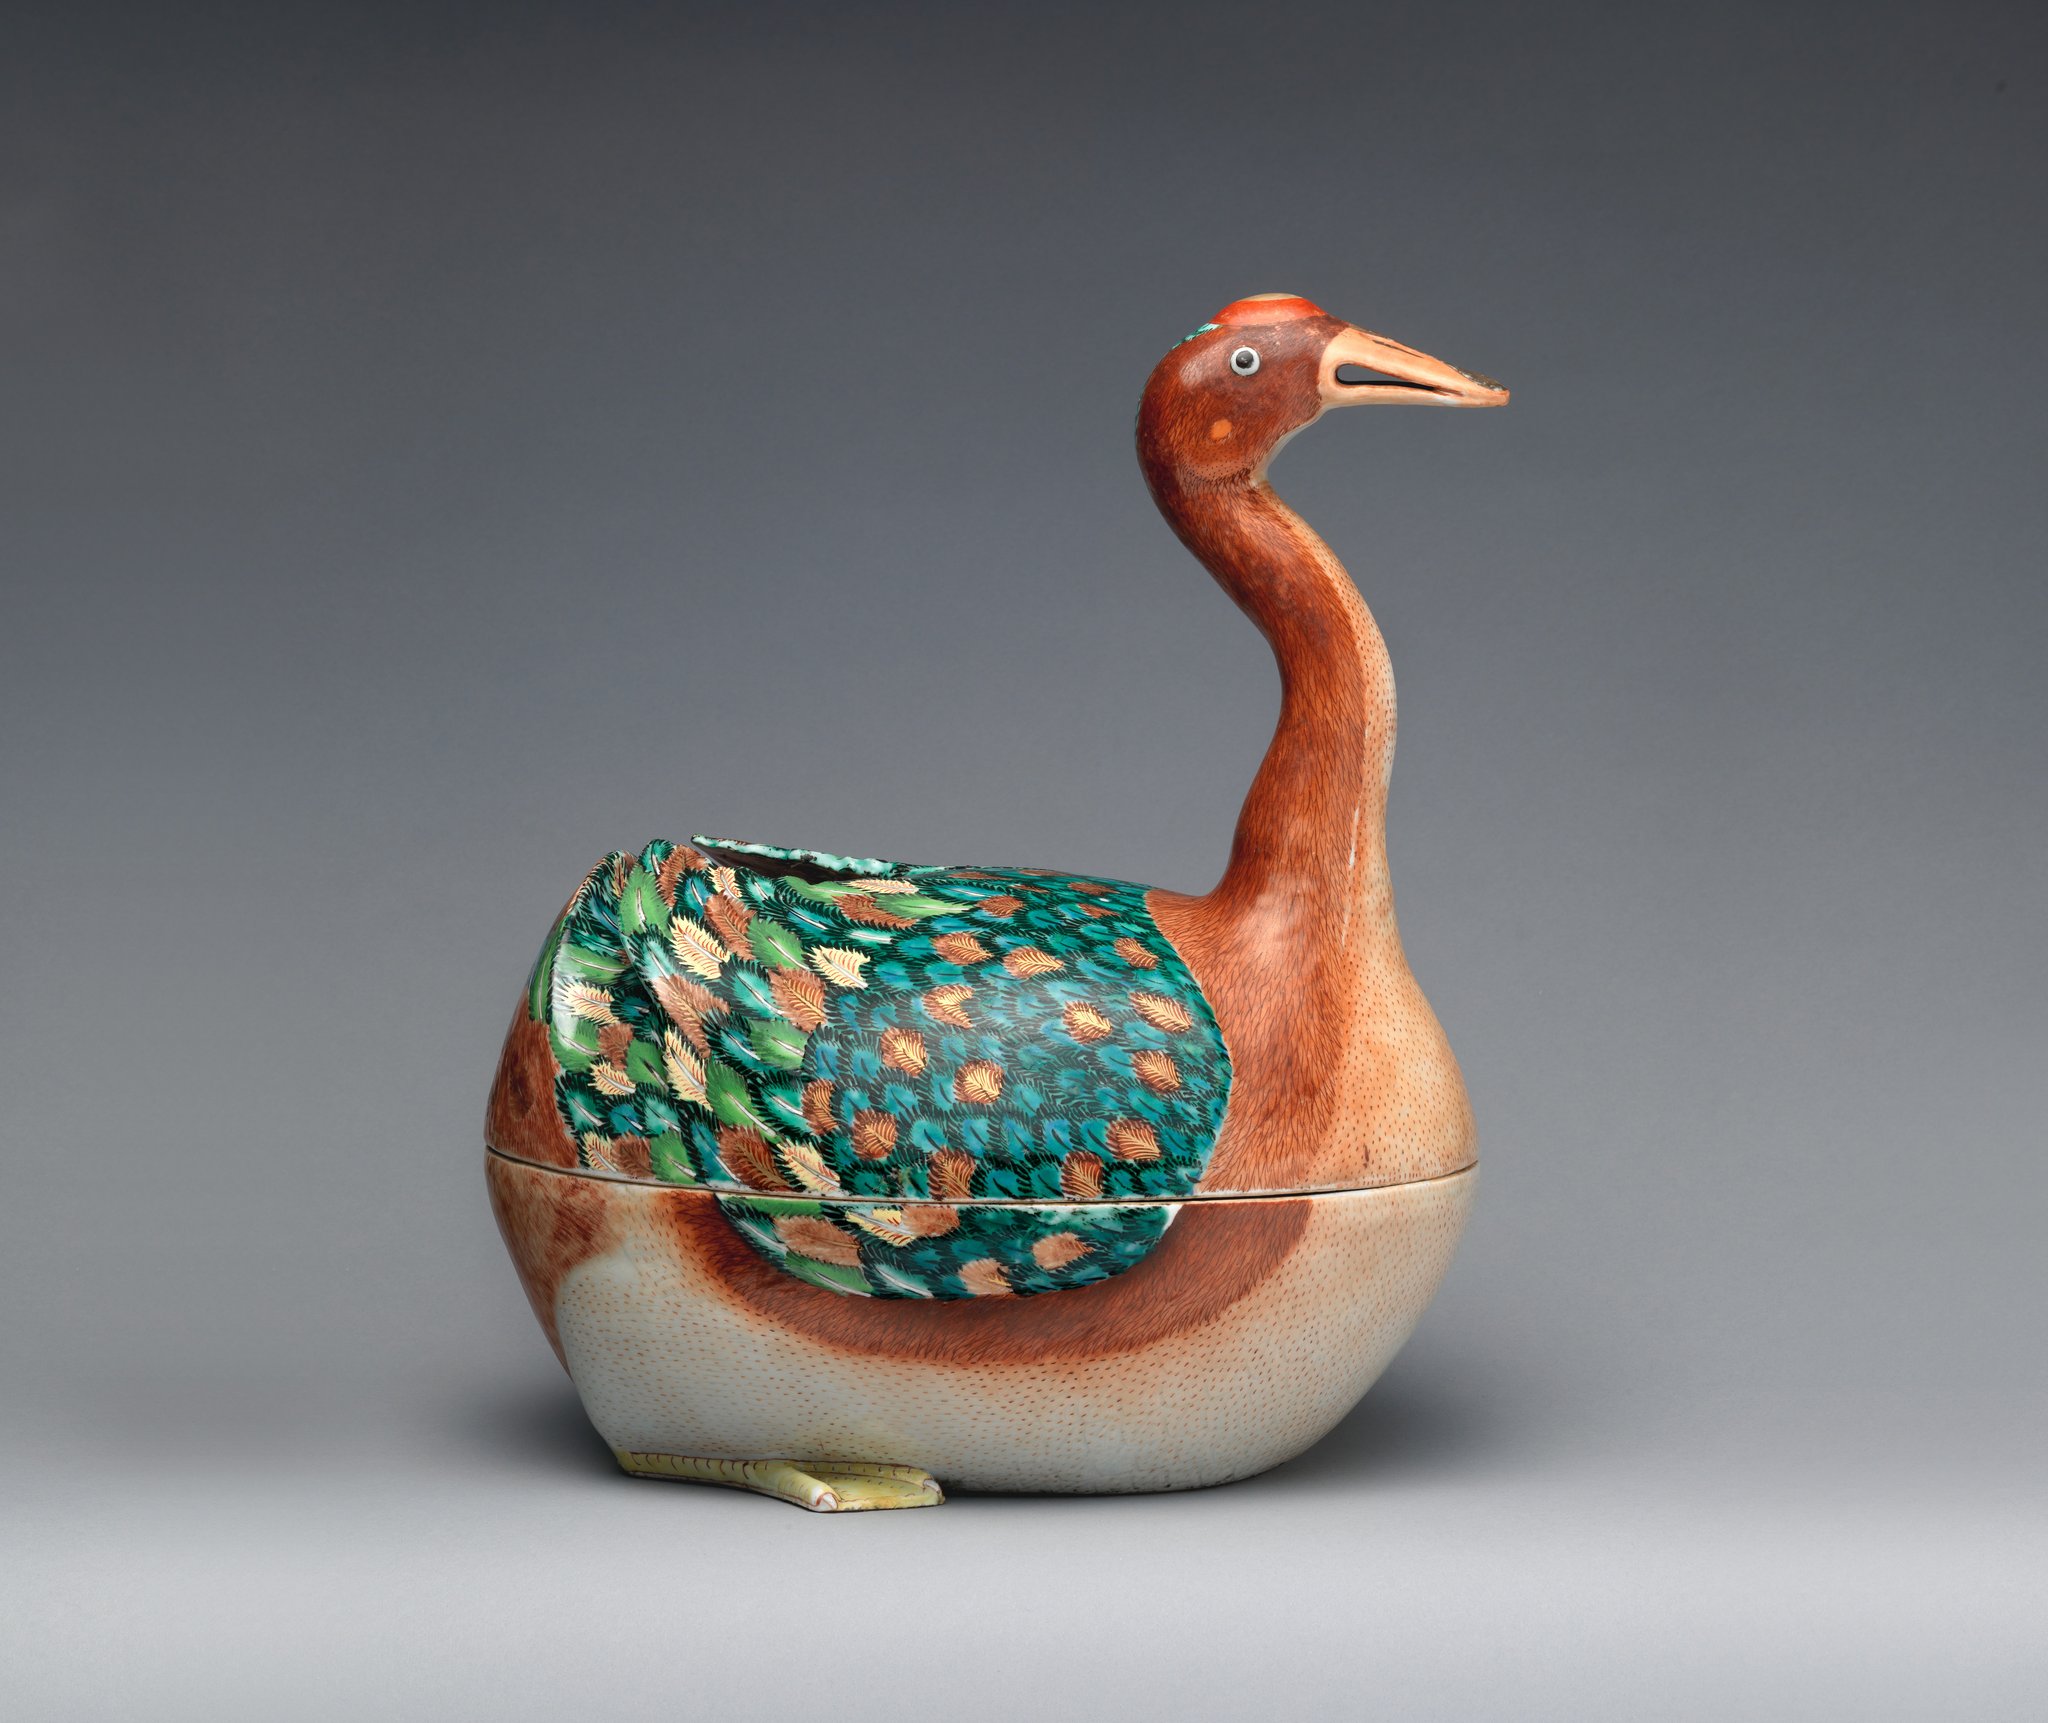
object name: tureen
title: Tureen in the form of a goose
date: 1770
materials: hard paste porcelain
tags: birds